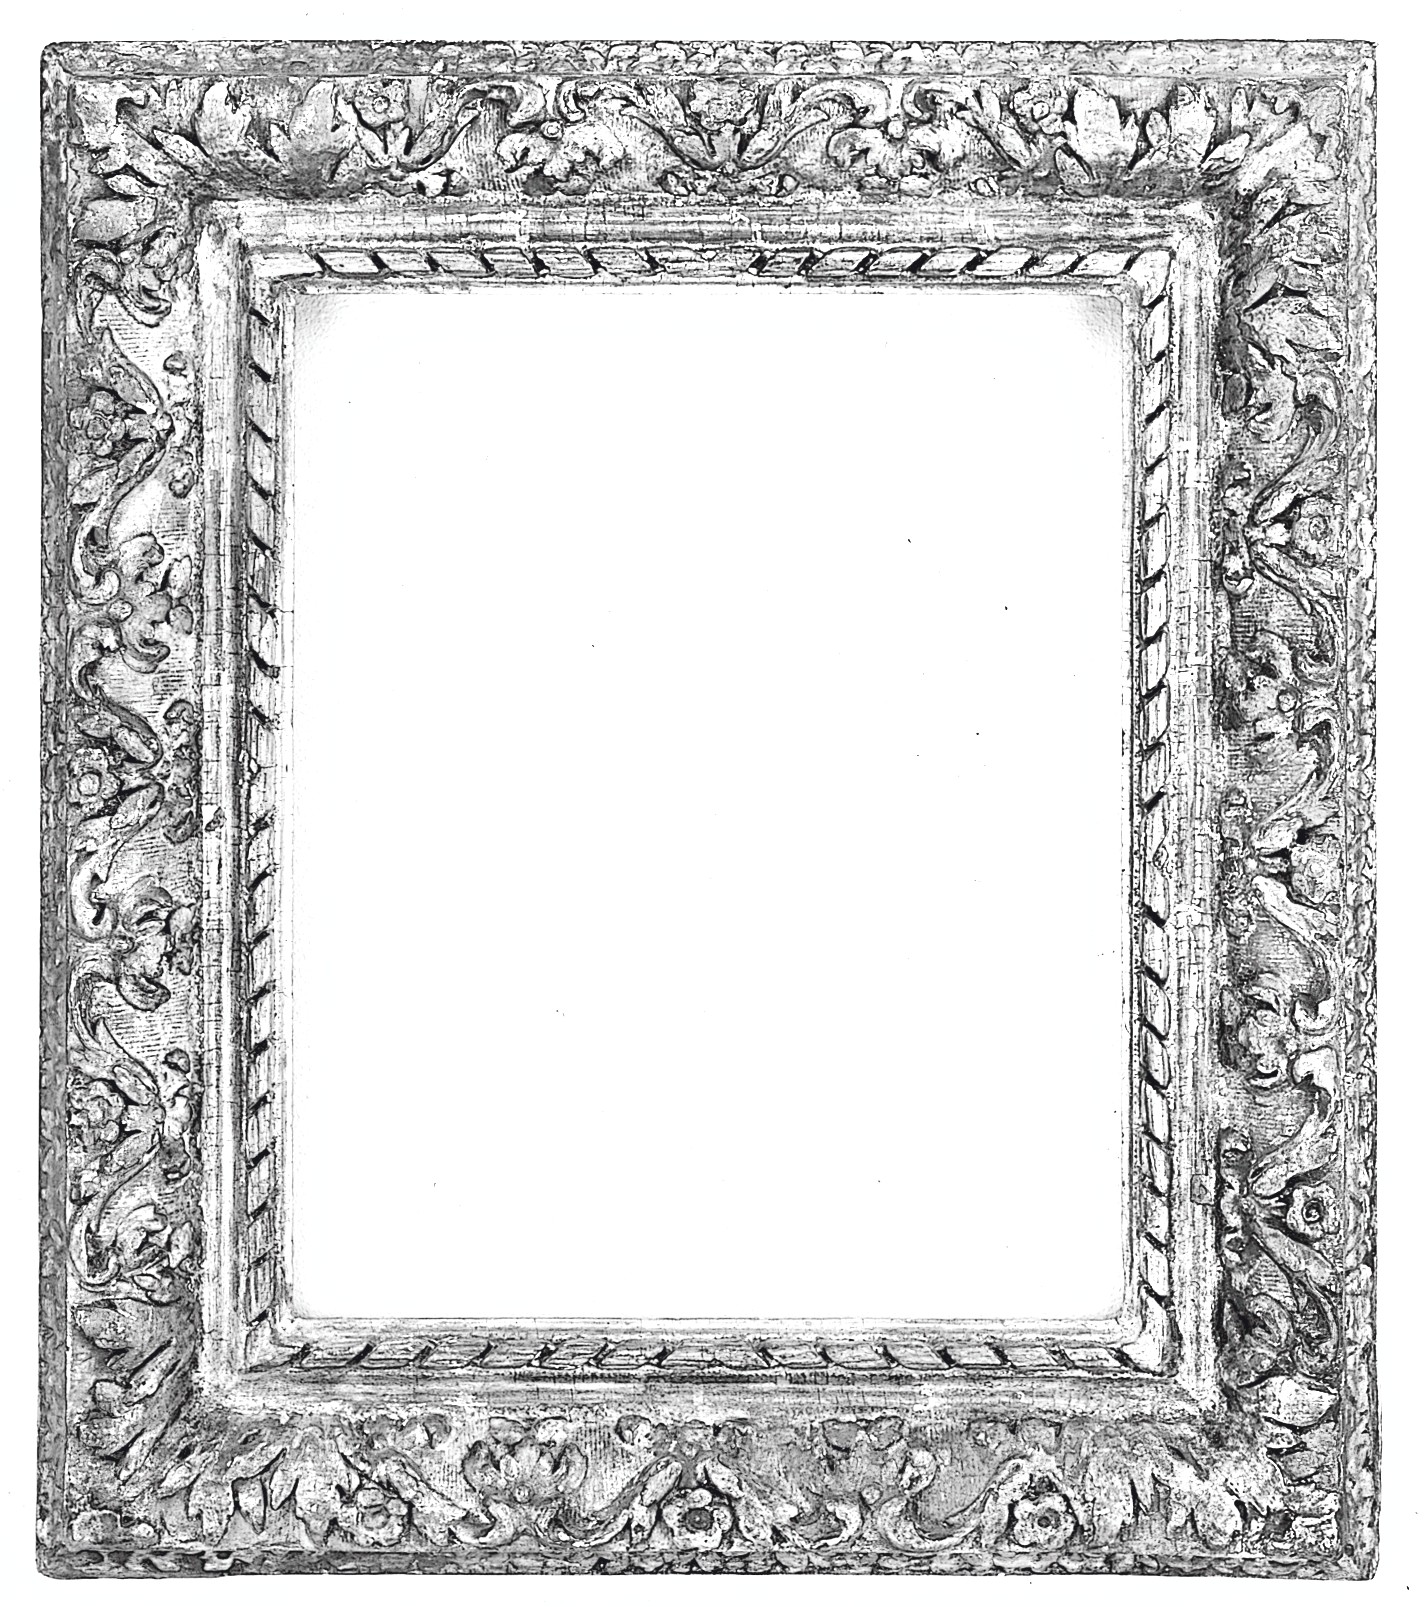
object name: frame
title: Ovolo frame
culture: italian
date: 1690-1700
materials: wood